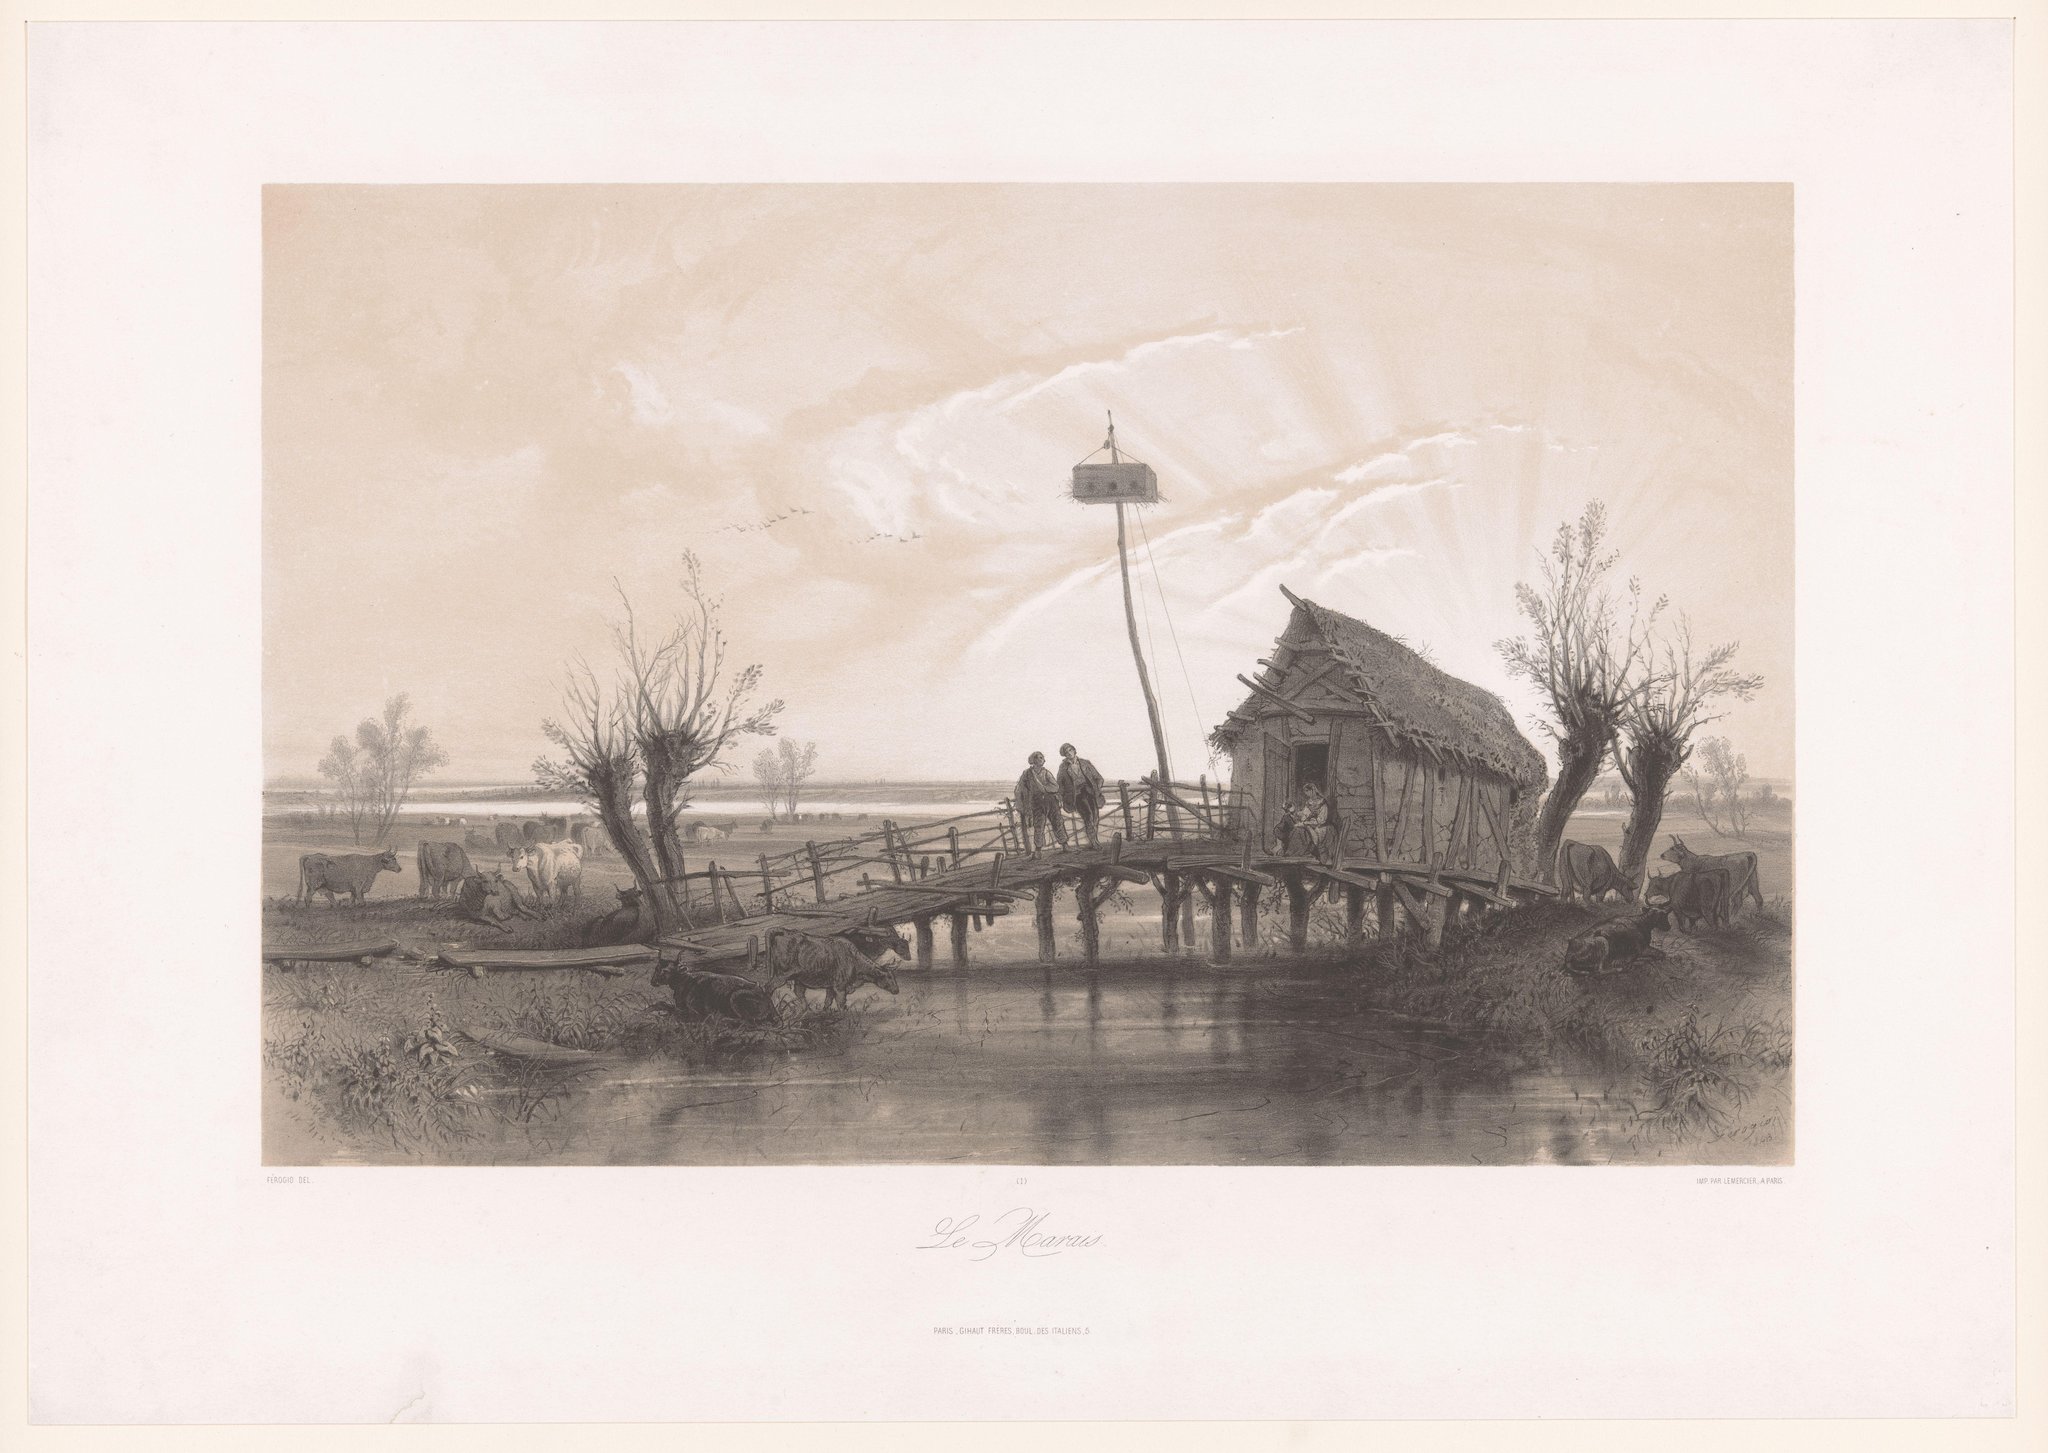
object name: print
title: Le Marais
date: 1843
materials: paper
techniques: lithograph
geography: paris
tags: swamp, inland marsh, fens, landscape with bridge, viaduct or aqueduct, sunbeams, hut, cabin, lodge, bovine cattle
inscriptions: collector's mark: Lugt 2228a